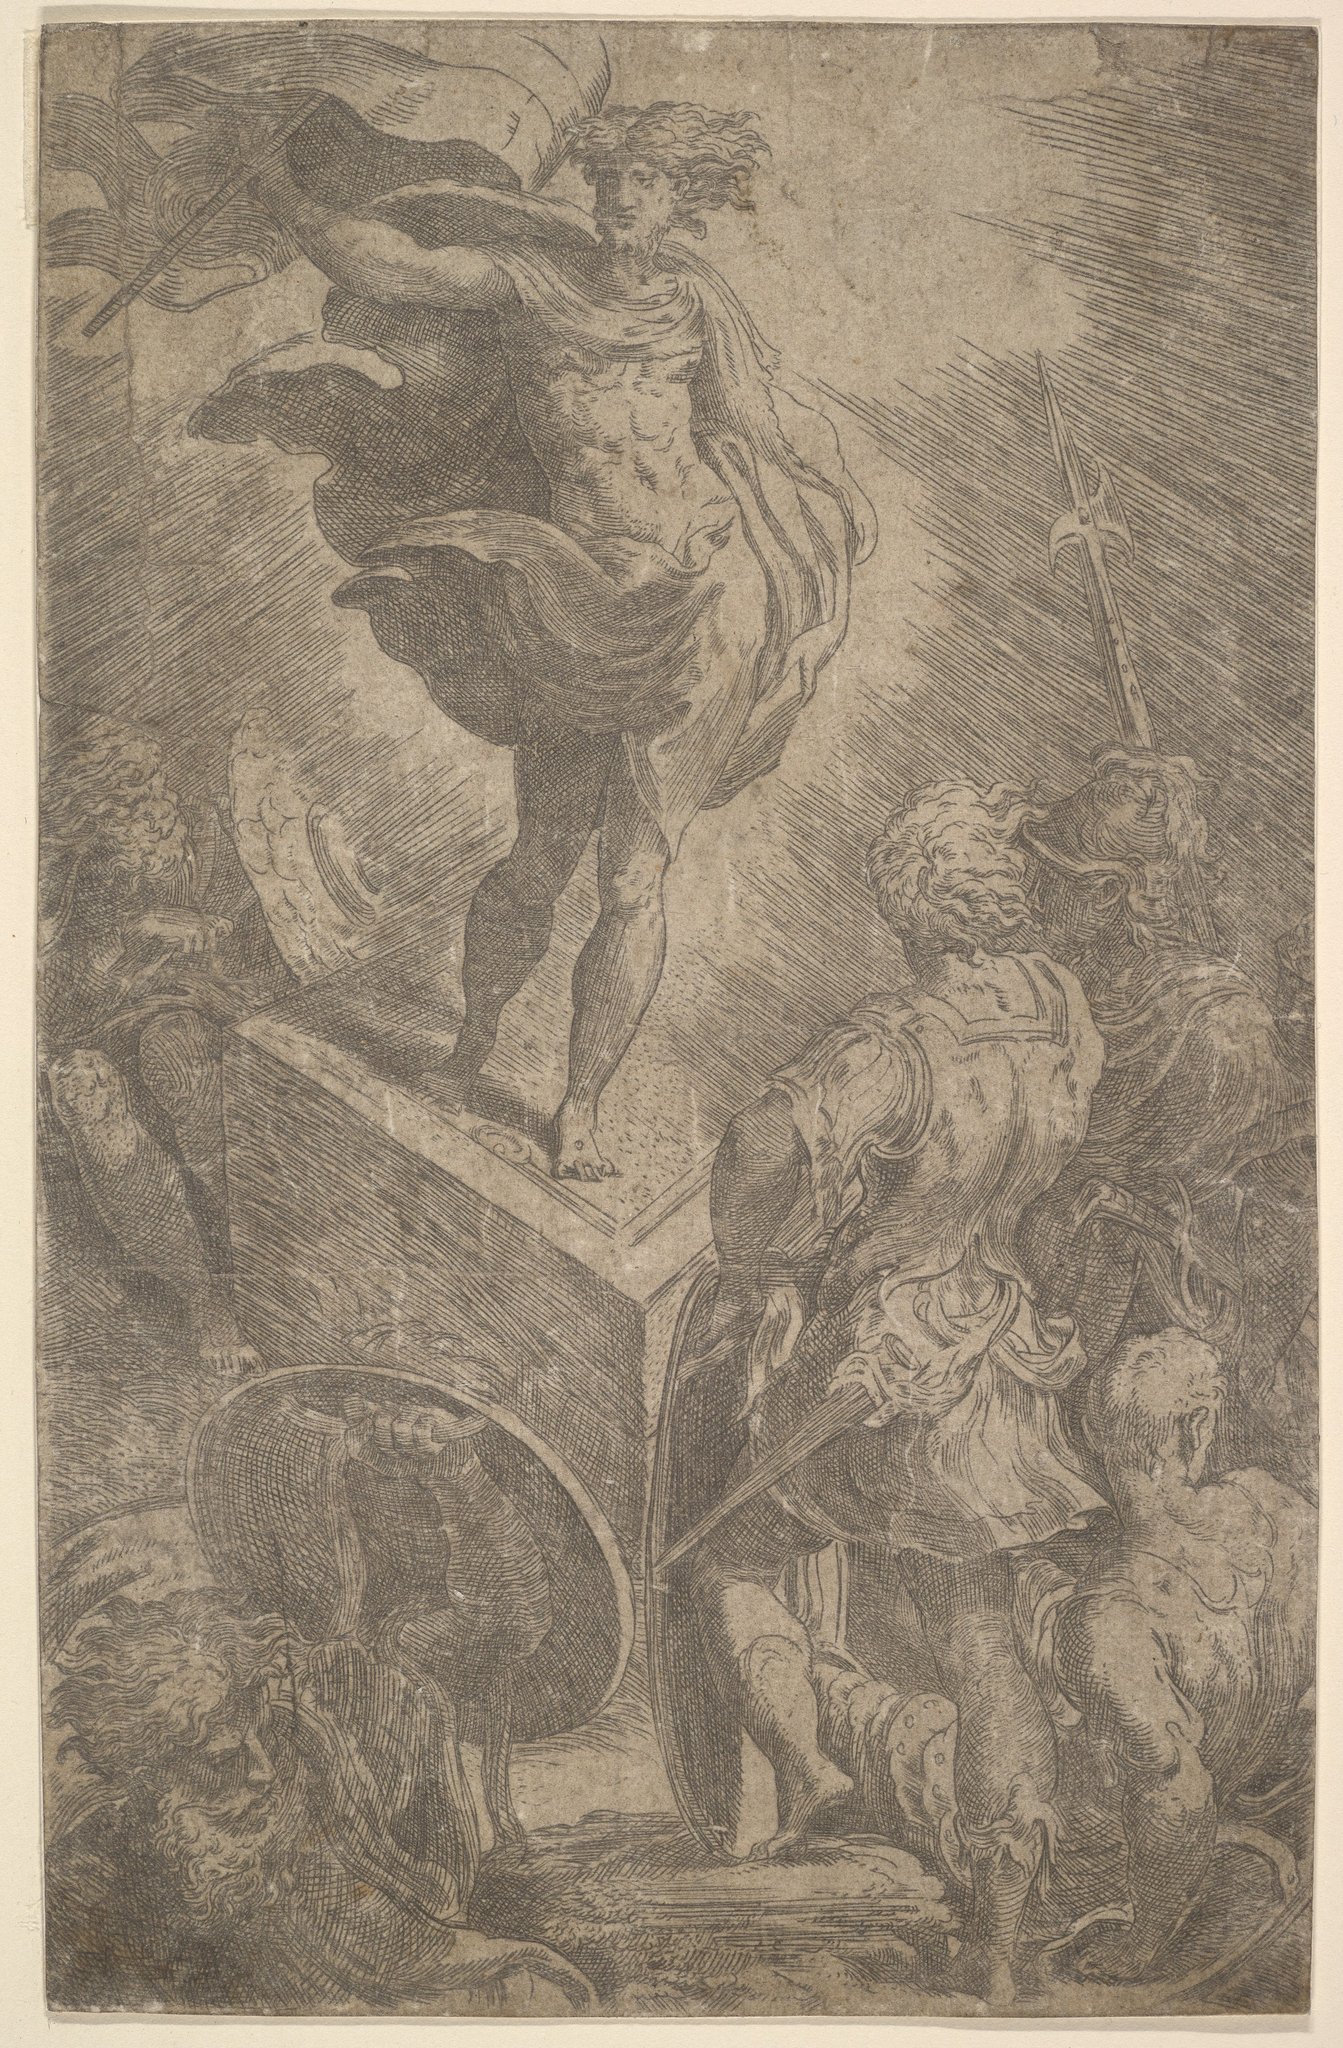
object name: print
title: Resurrection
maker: parmigianino (girolamo francesco maria mazzola)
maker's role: artist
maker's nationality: italian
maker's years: 1503-1540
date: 1501-1533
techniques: etching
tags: soldiers,christ